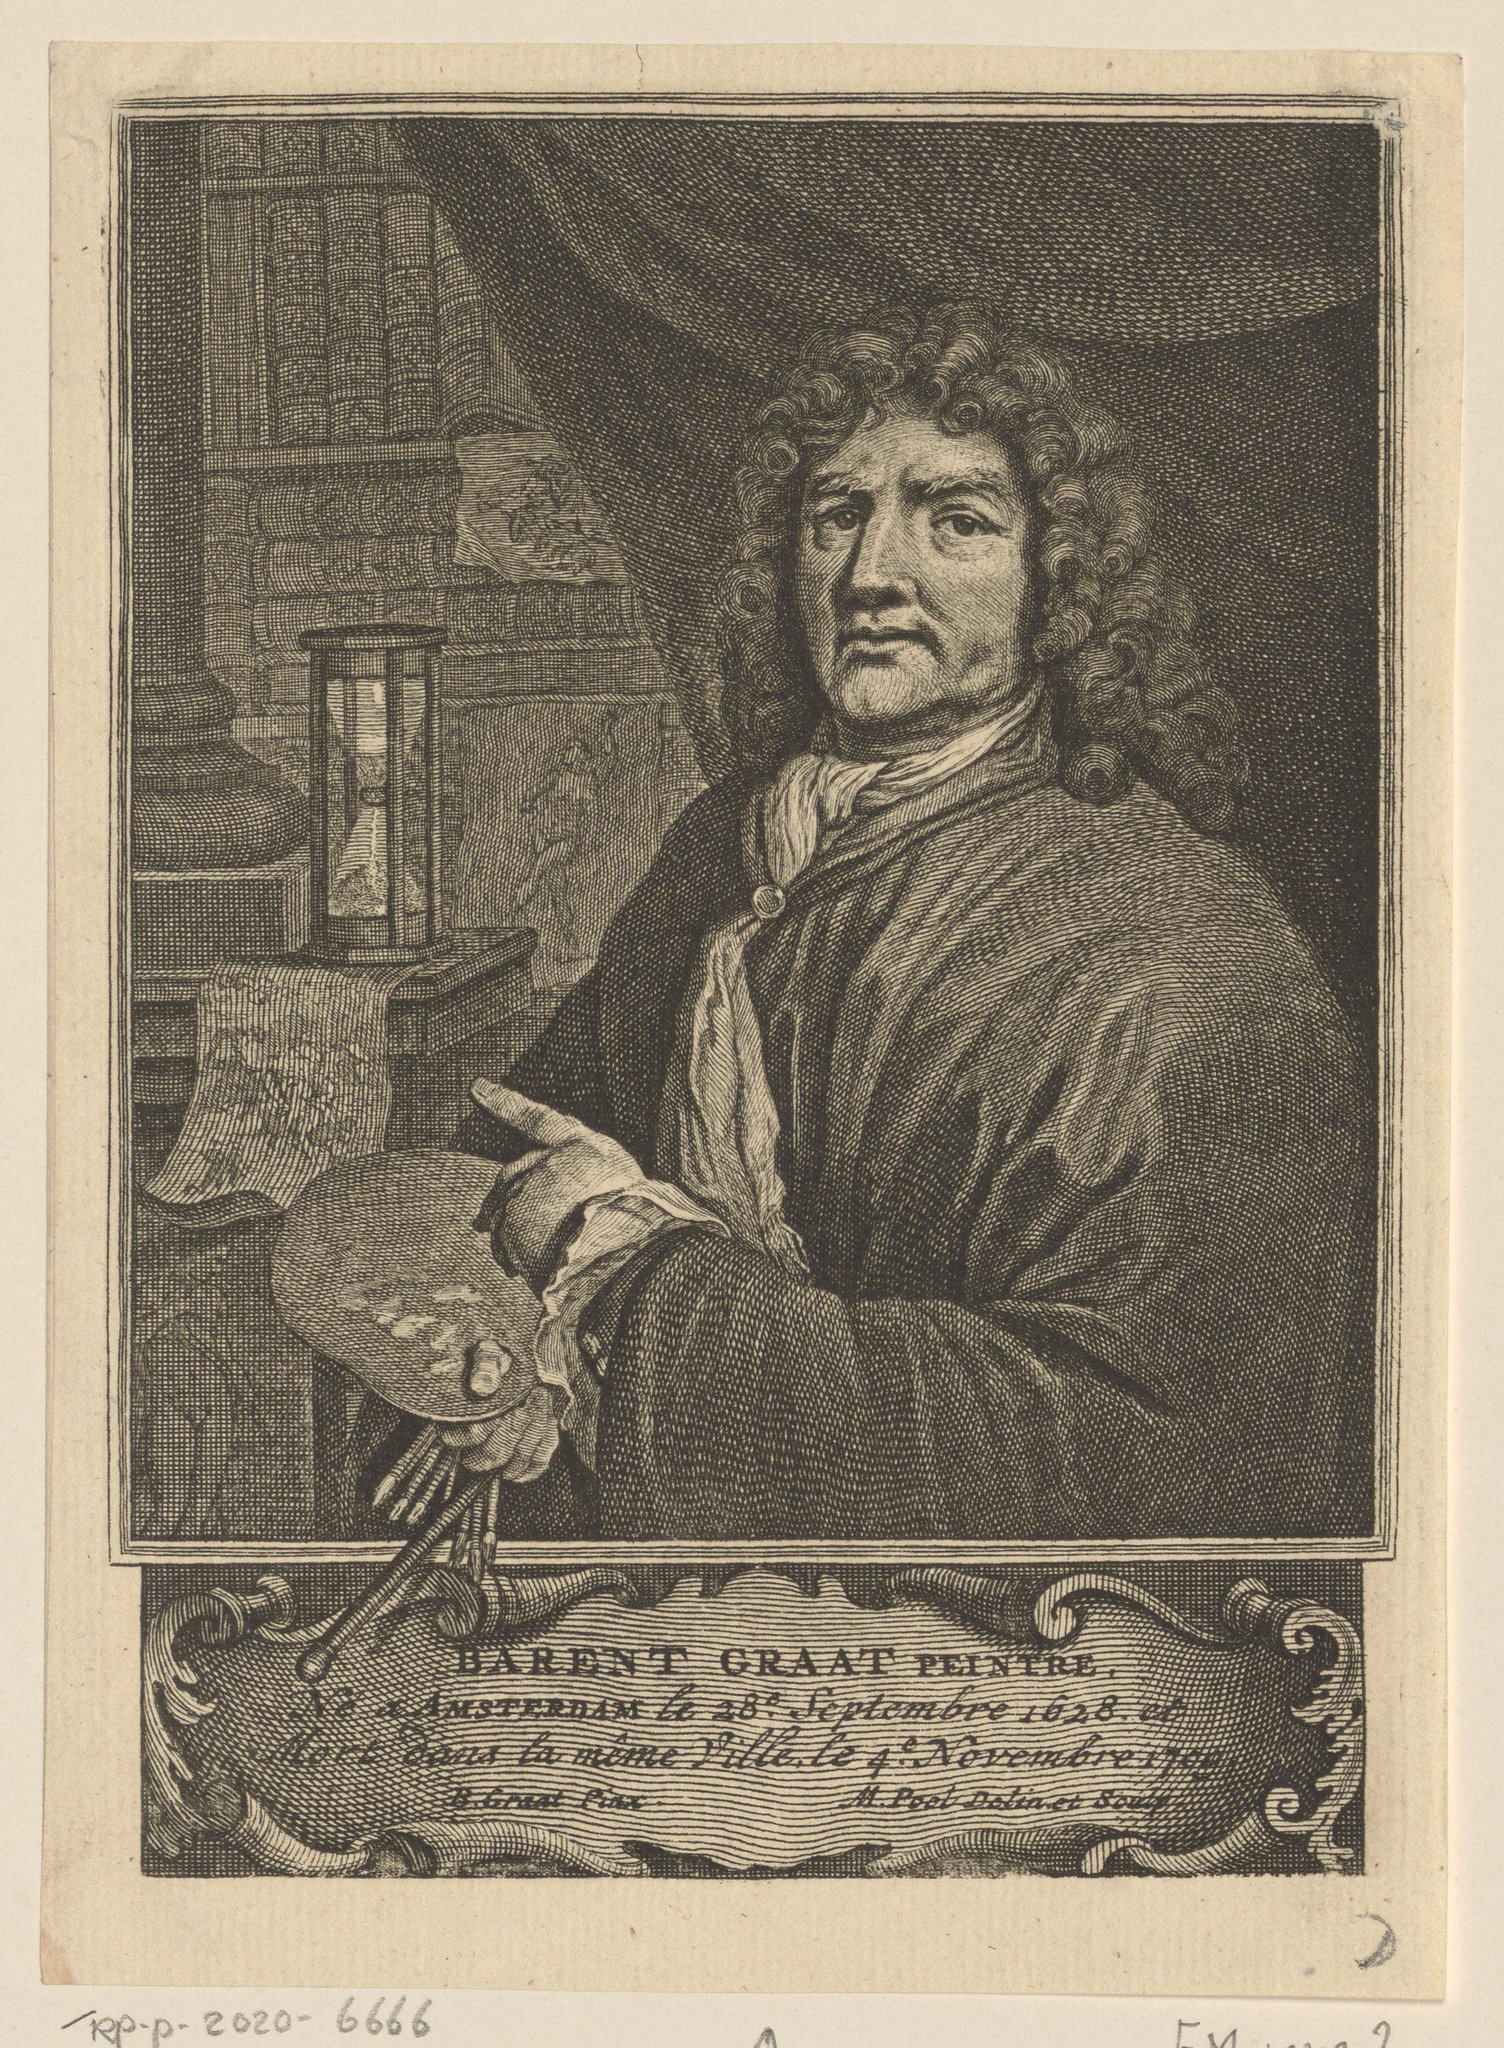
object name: print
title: Portret van Barend Graat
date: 1727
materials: paper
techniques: engraving, etching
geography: amsterdam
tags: amsterdam, print maker, draughtsman, barend graat, historical persons, portrait, self-portrait of painter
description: Prent uit: Bossuit, Francis van. Cabinet de l'art de schulpture par le fameux sculpteur Francis van Bossuit (...). Amsterdam: Matthijs Pool, 1727.